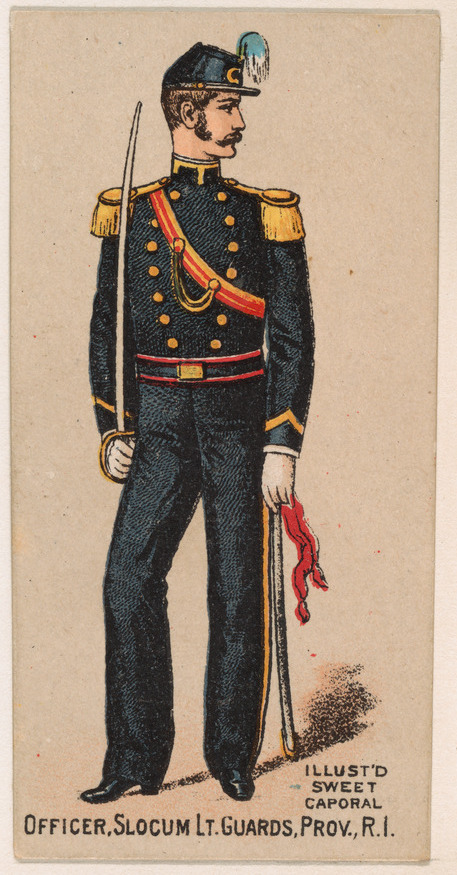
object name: print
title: Officer, Slocum Light Guards, Providence, Rhode Island, from the Military Series (N224) issued by Kinney Tobacco Company to promote Sweet Caporal Cigarettes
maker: kinney brothers tobacco company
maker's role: publisher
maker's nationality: american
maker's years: 1869-2011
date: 1888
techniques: color lithograph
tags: military,swords,men,profiles